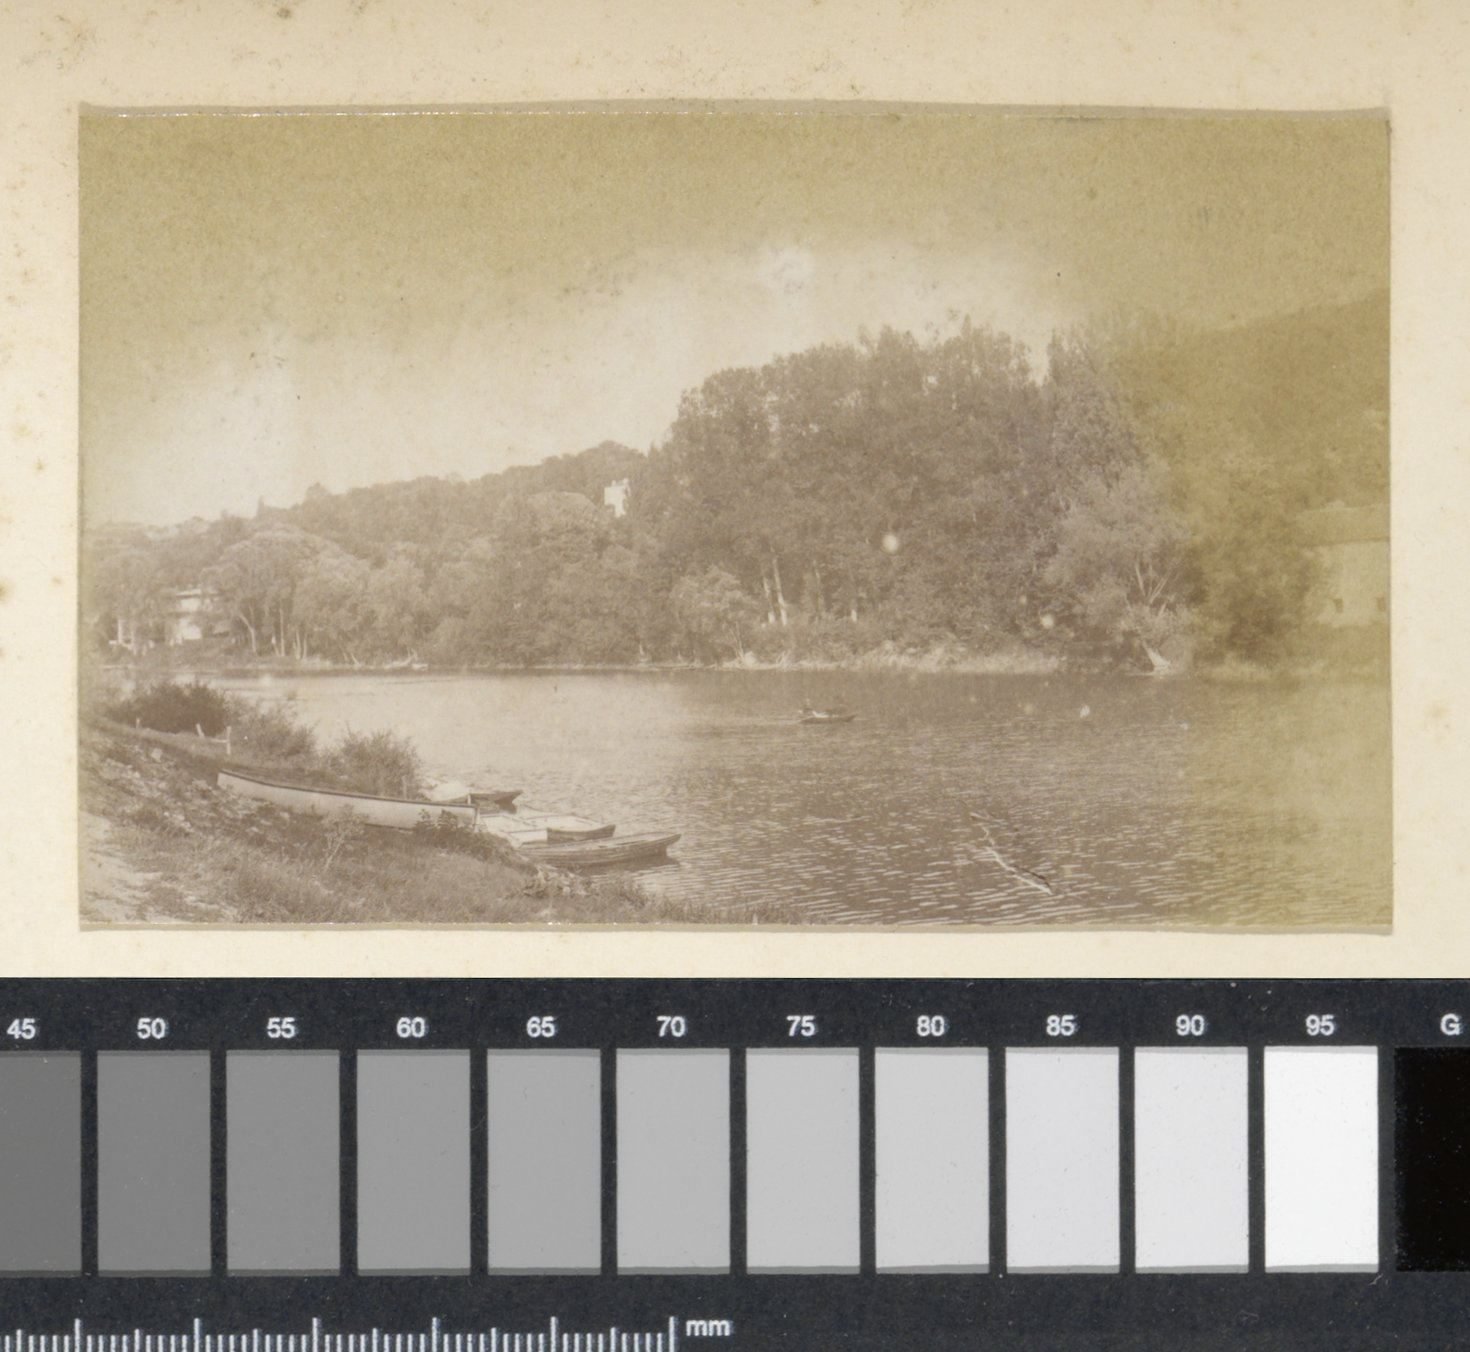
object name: photograph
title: Rivierlandschap in Frankrijk met op de voorgrond een aanlegsteiger voor roeiboten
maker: Anonymous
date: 1900-1910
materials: paper, photographic support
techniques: albumen print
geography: france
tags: rowing-boat, canoe, etc., pier, quay, wharf, river (+ landscape with figures, staffage), france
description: Onderdeel van Fotoalbum van een Franse amateurfotograaf met opnames van een familie, distilleerderij Delizy & Doistau Fils, het leger en bezienswaardigheden in Frankrijk.